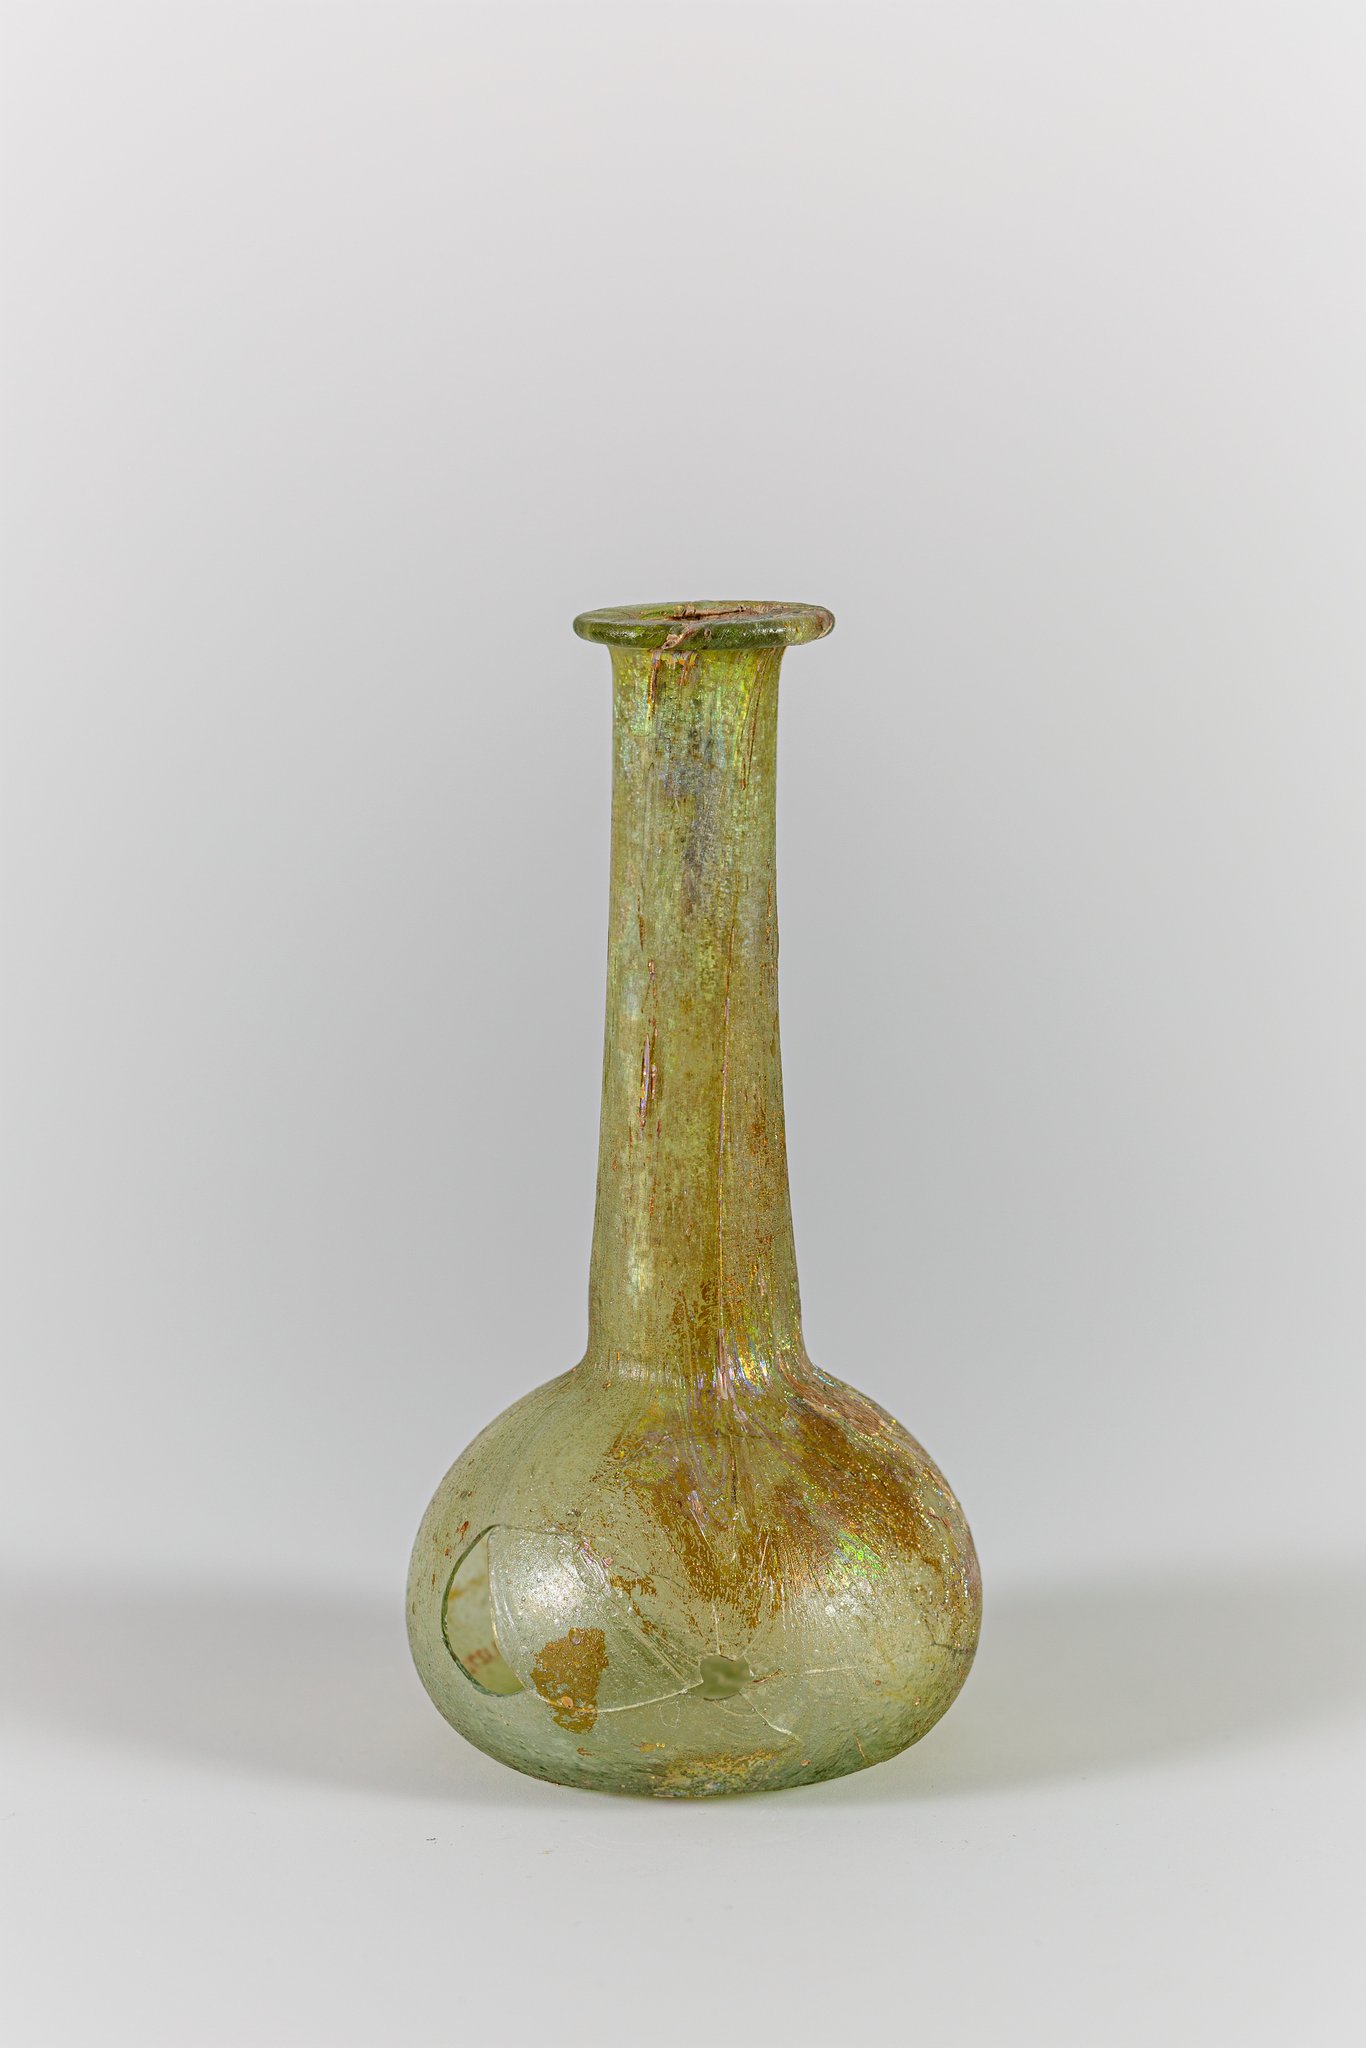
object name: perfume bottle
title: Glass perfume bottle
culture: roman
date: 101-300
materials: glass